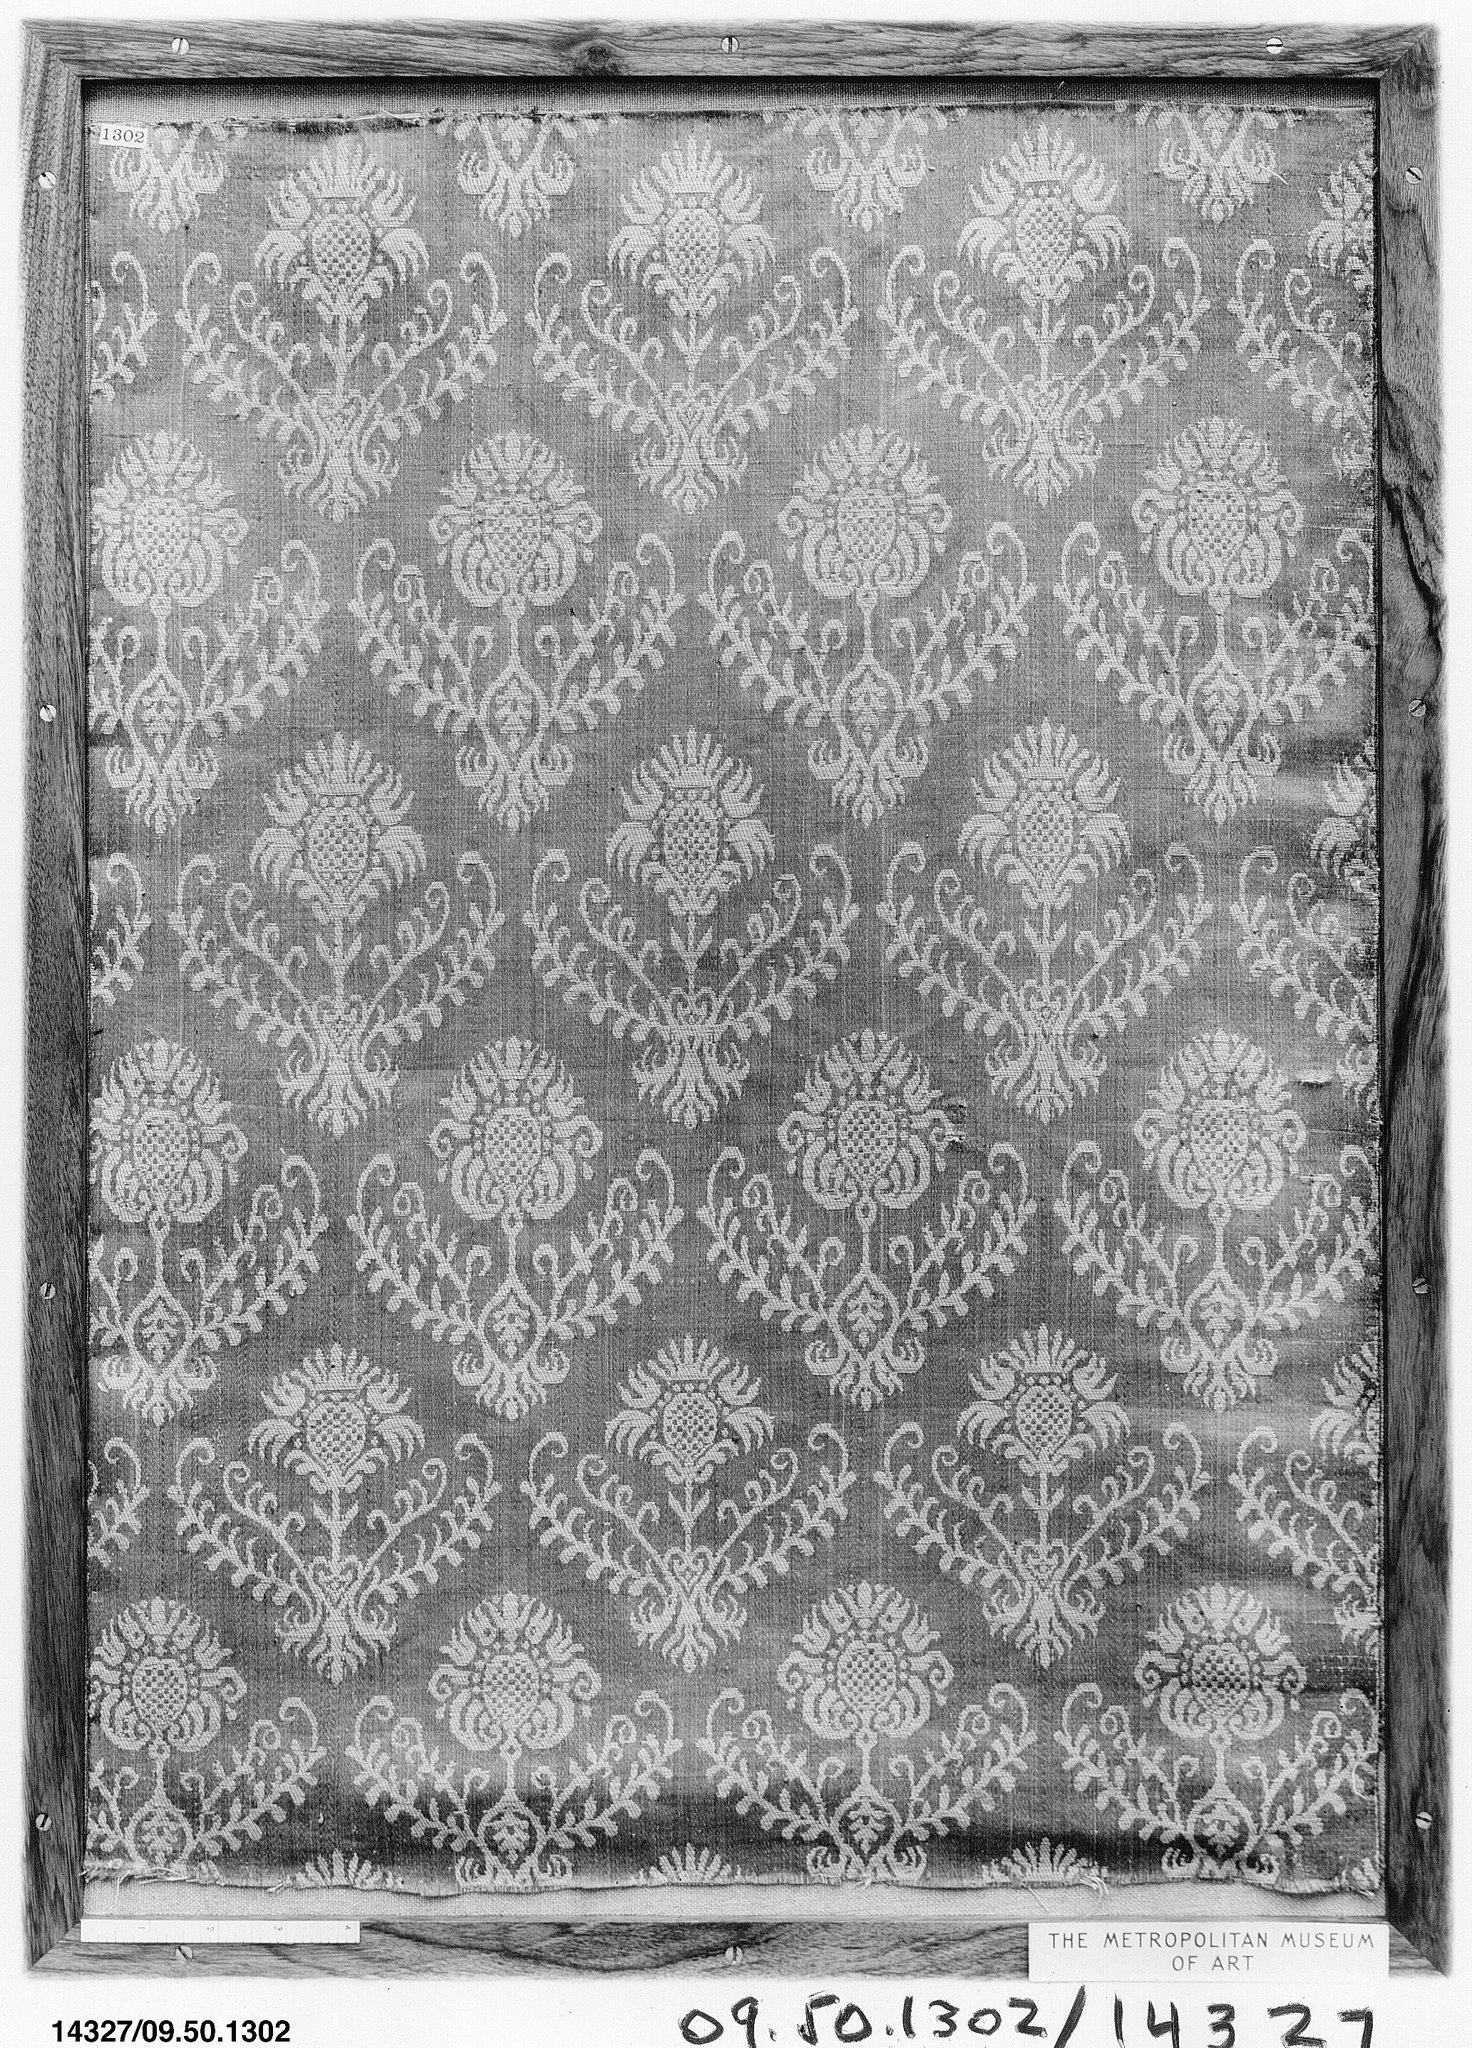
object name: fragment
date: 1701-1800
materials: linen, silk